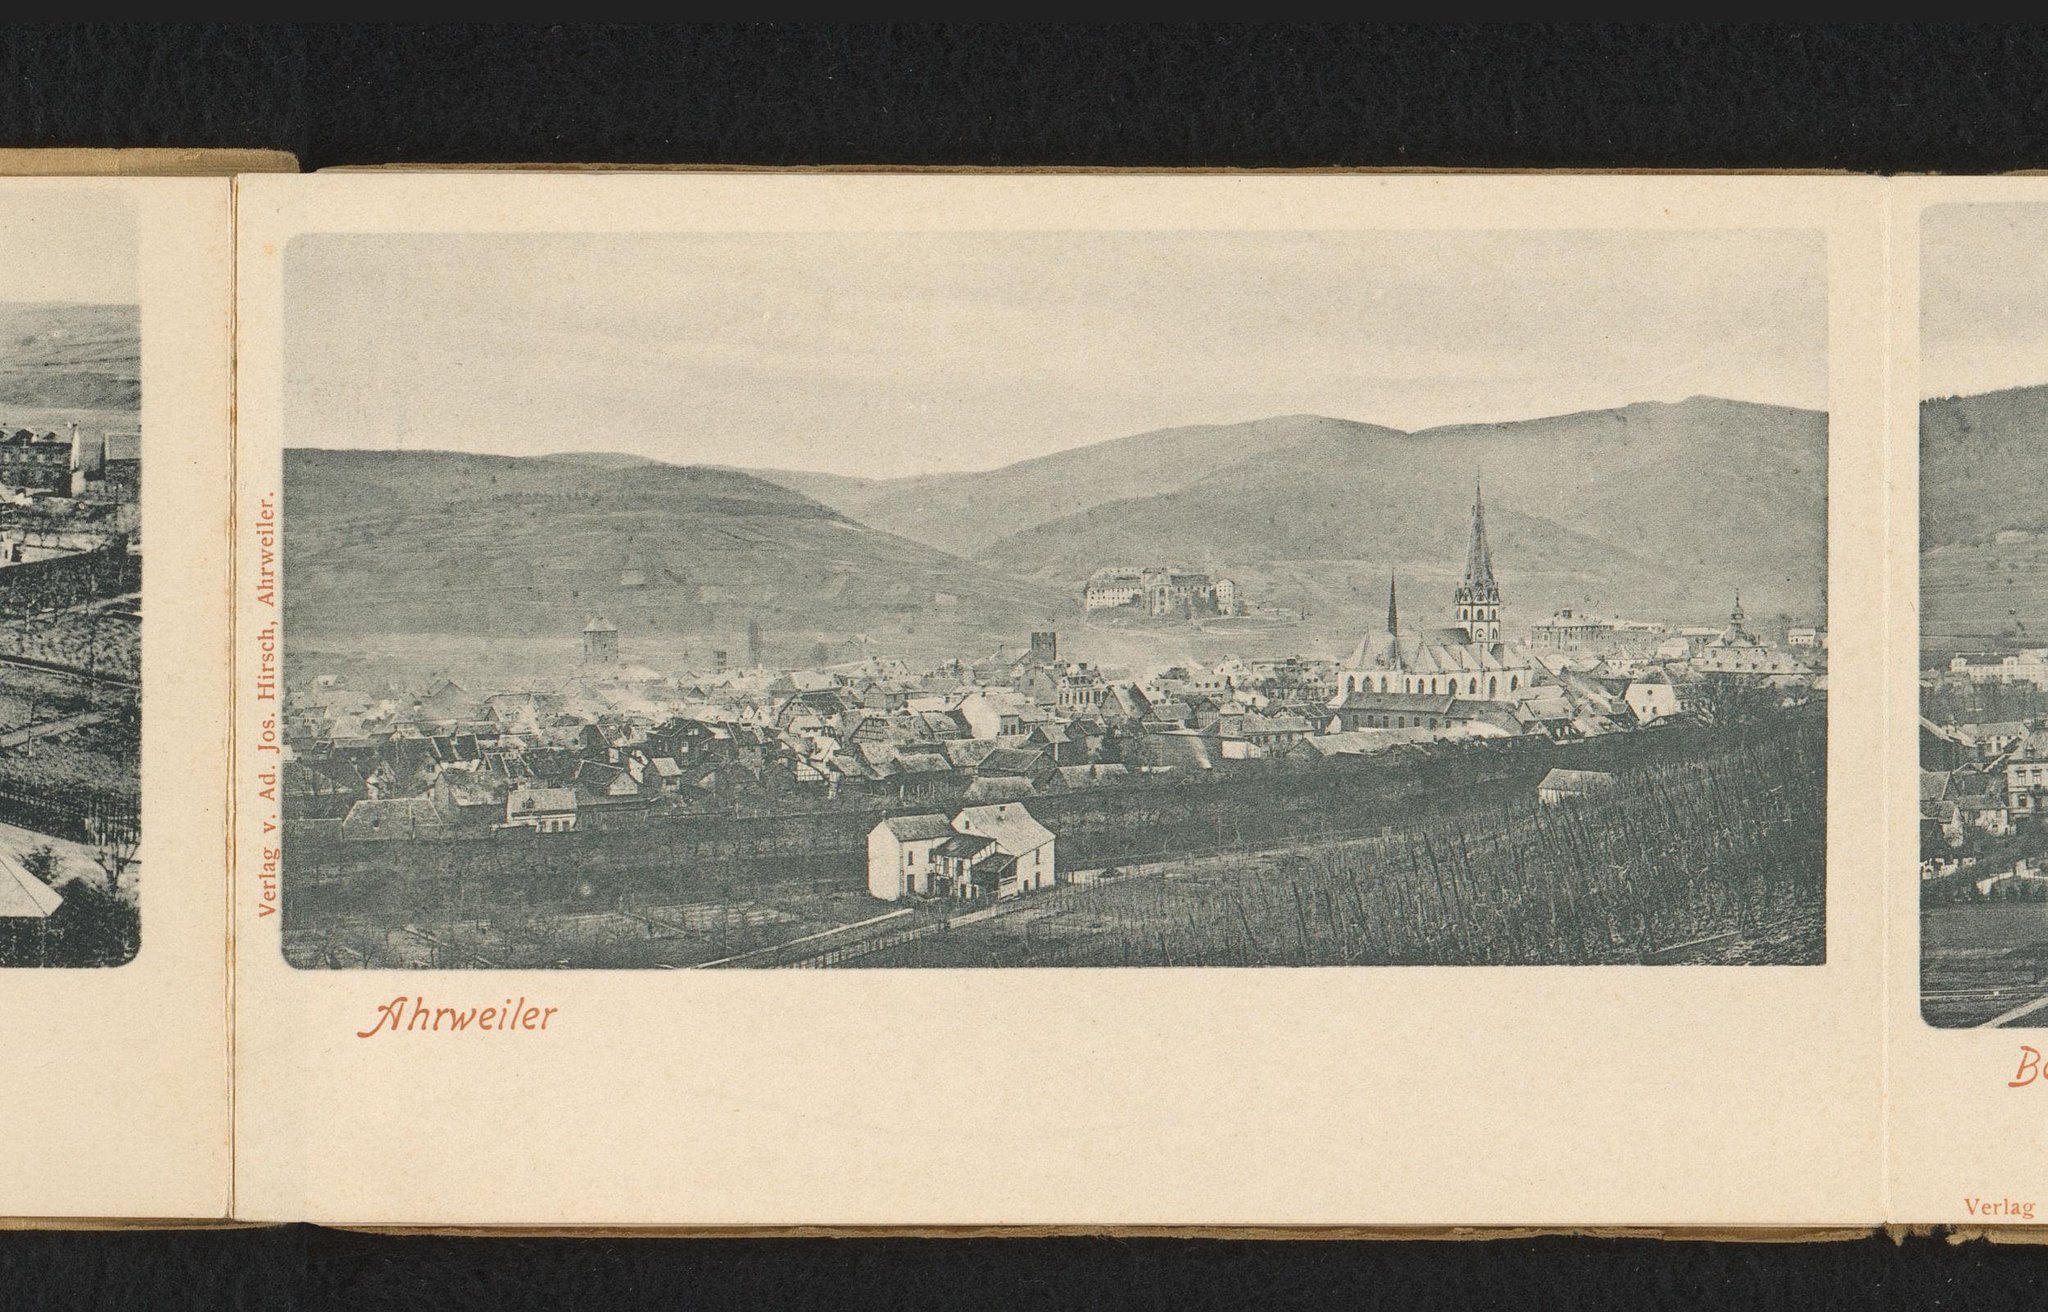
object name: ansichtkaart, prentbriefkaart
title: Ahrweiler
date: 1885-1903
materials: cardboard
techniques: photograph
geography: ahrweiler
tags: city-view, and landscape with man-made constructions, church (exterior), mountains